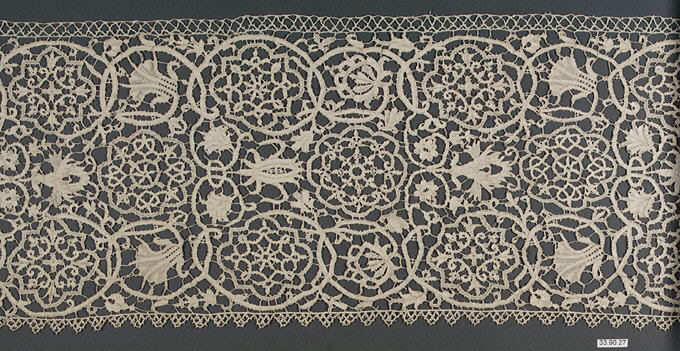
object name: border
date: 1601-1633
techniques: lace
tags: flowers